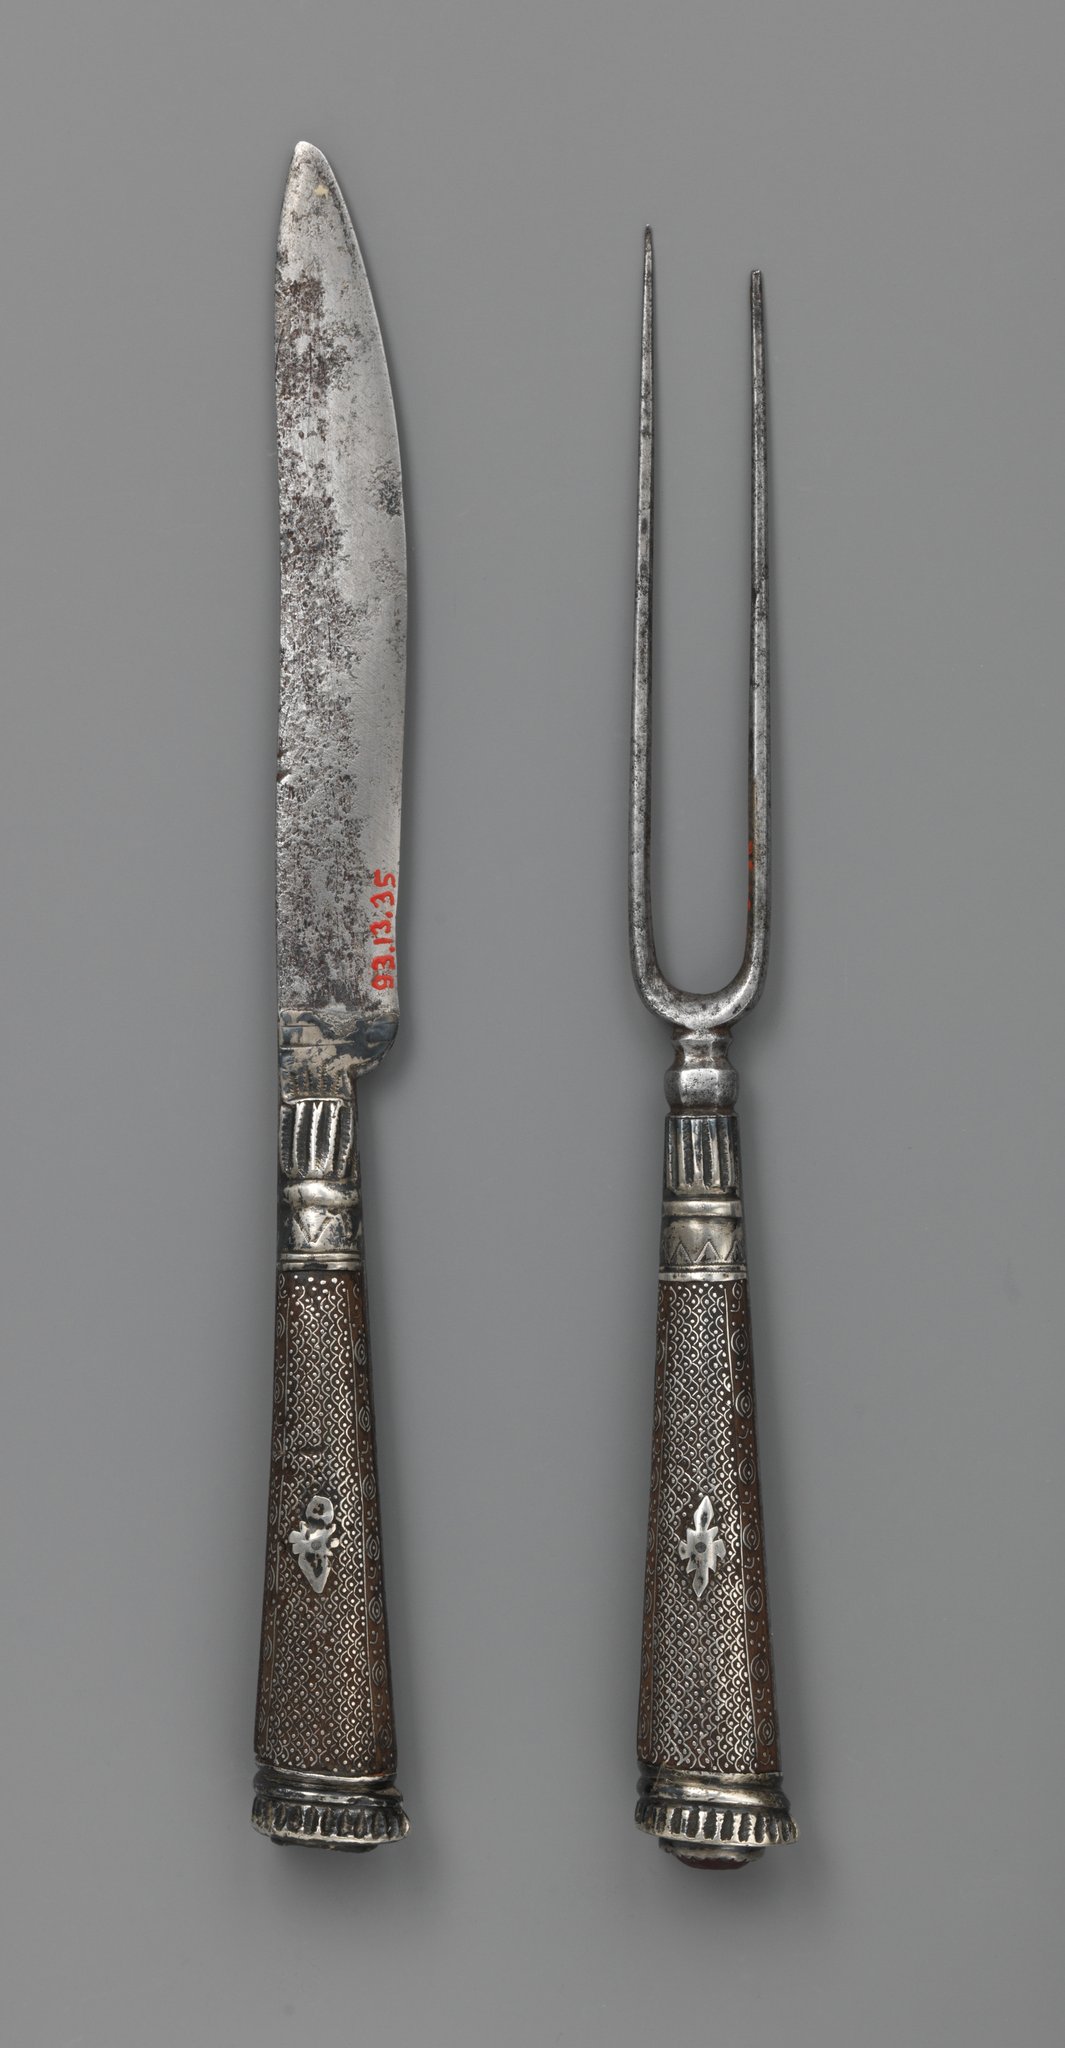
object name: table knife and fork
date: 1601-1700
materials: glass, silver, steel, stone, wood